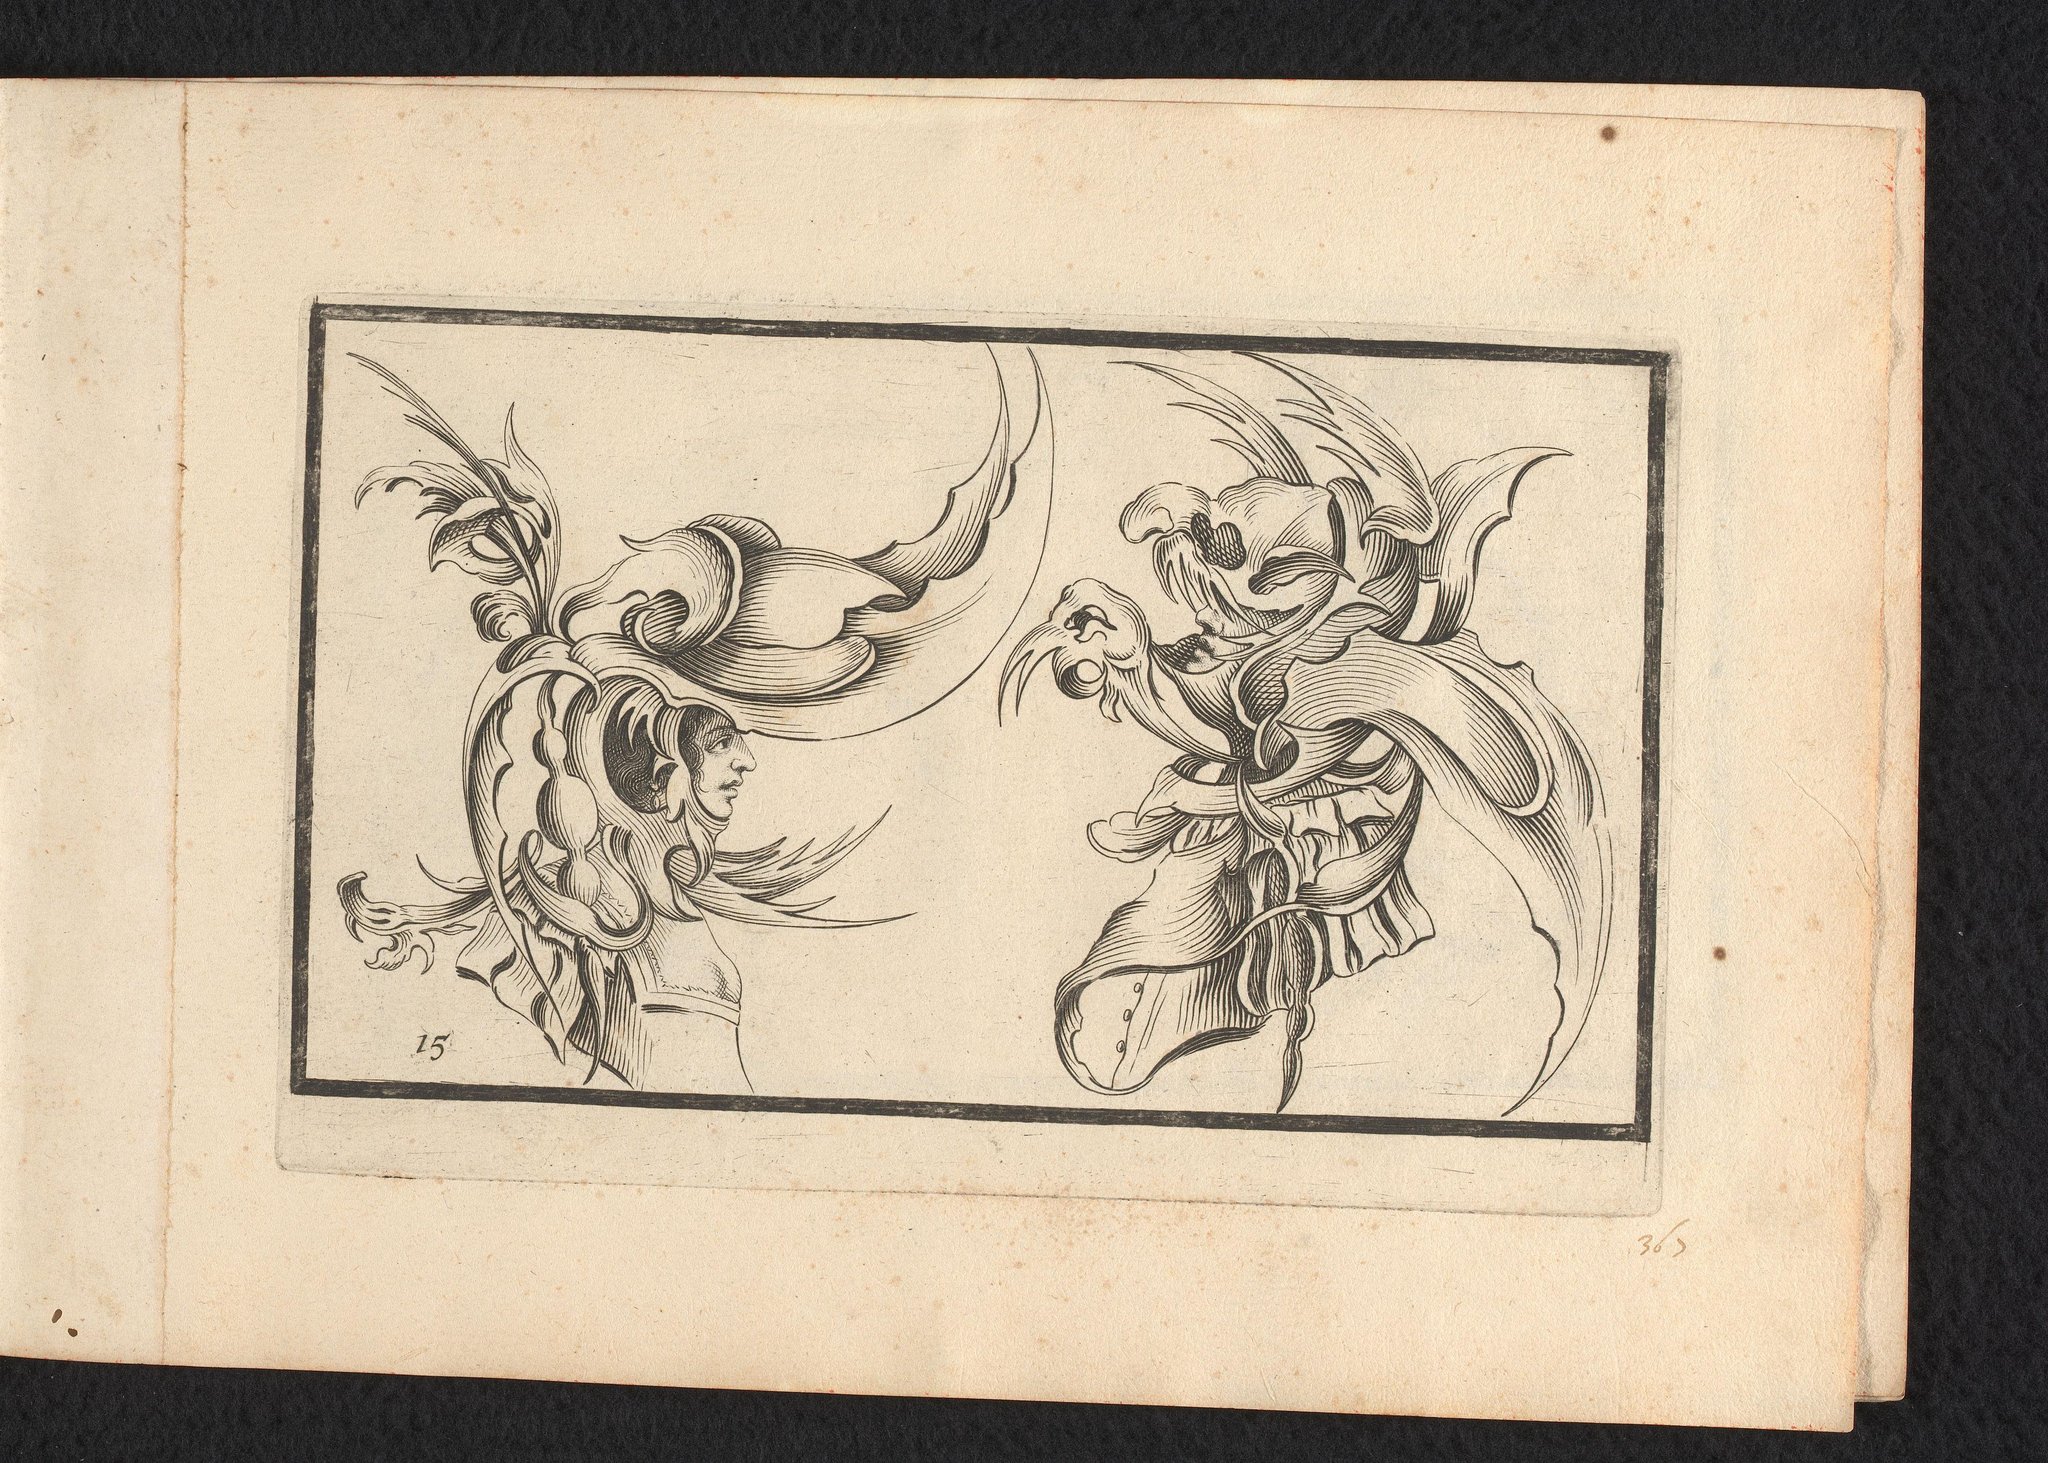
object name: print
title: Vrouwen- en mannenkop met groteske hoofdbedekking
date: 1636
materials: paper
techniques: engraving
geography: paris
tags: ornaments ~ art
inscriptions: number: ‘367’, collector's mark: Lugt 2760, collector's mark: Lugt 2228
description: Deze prent maakt deel uit van een album.